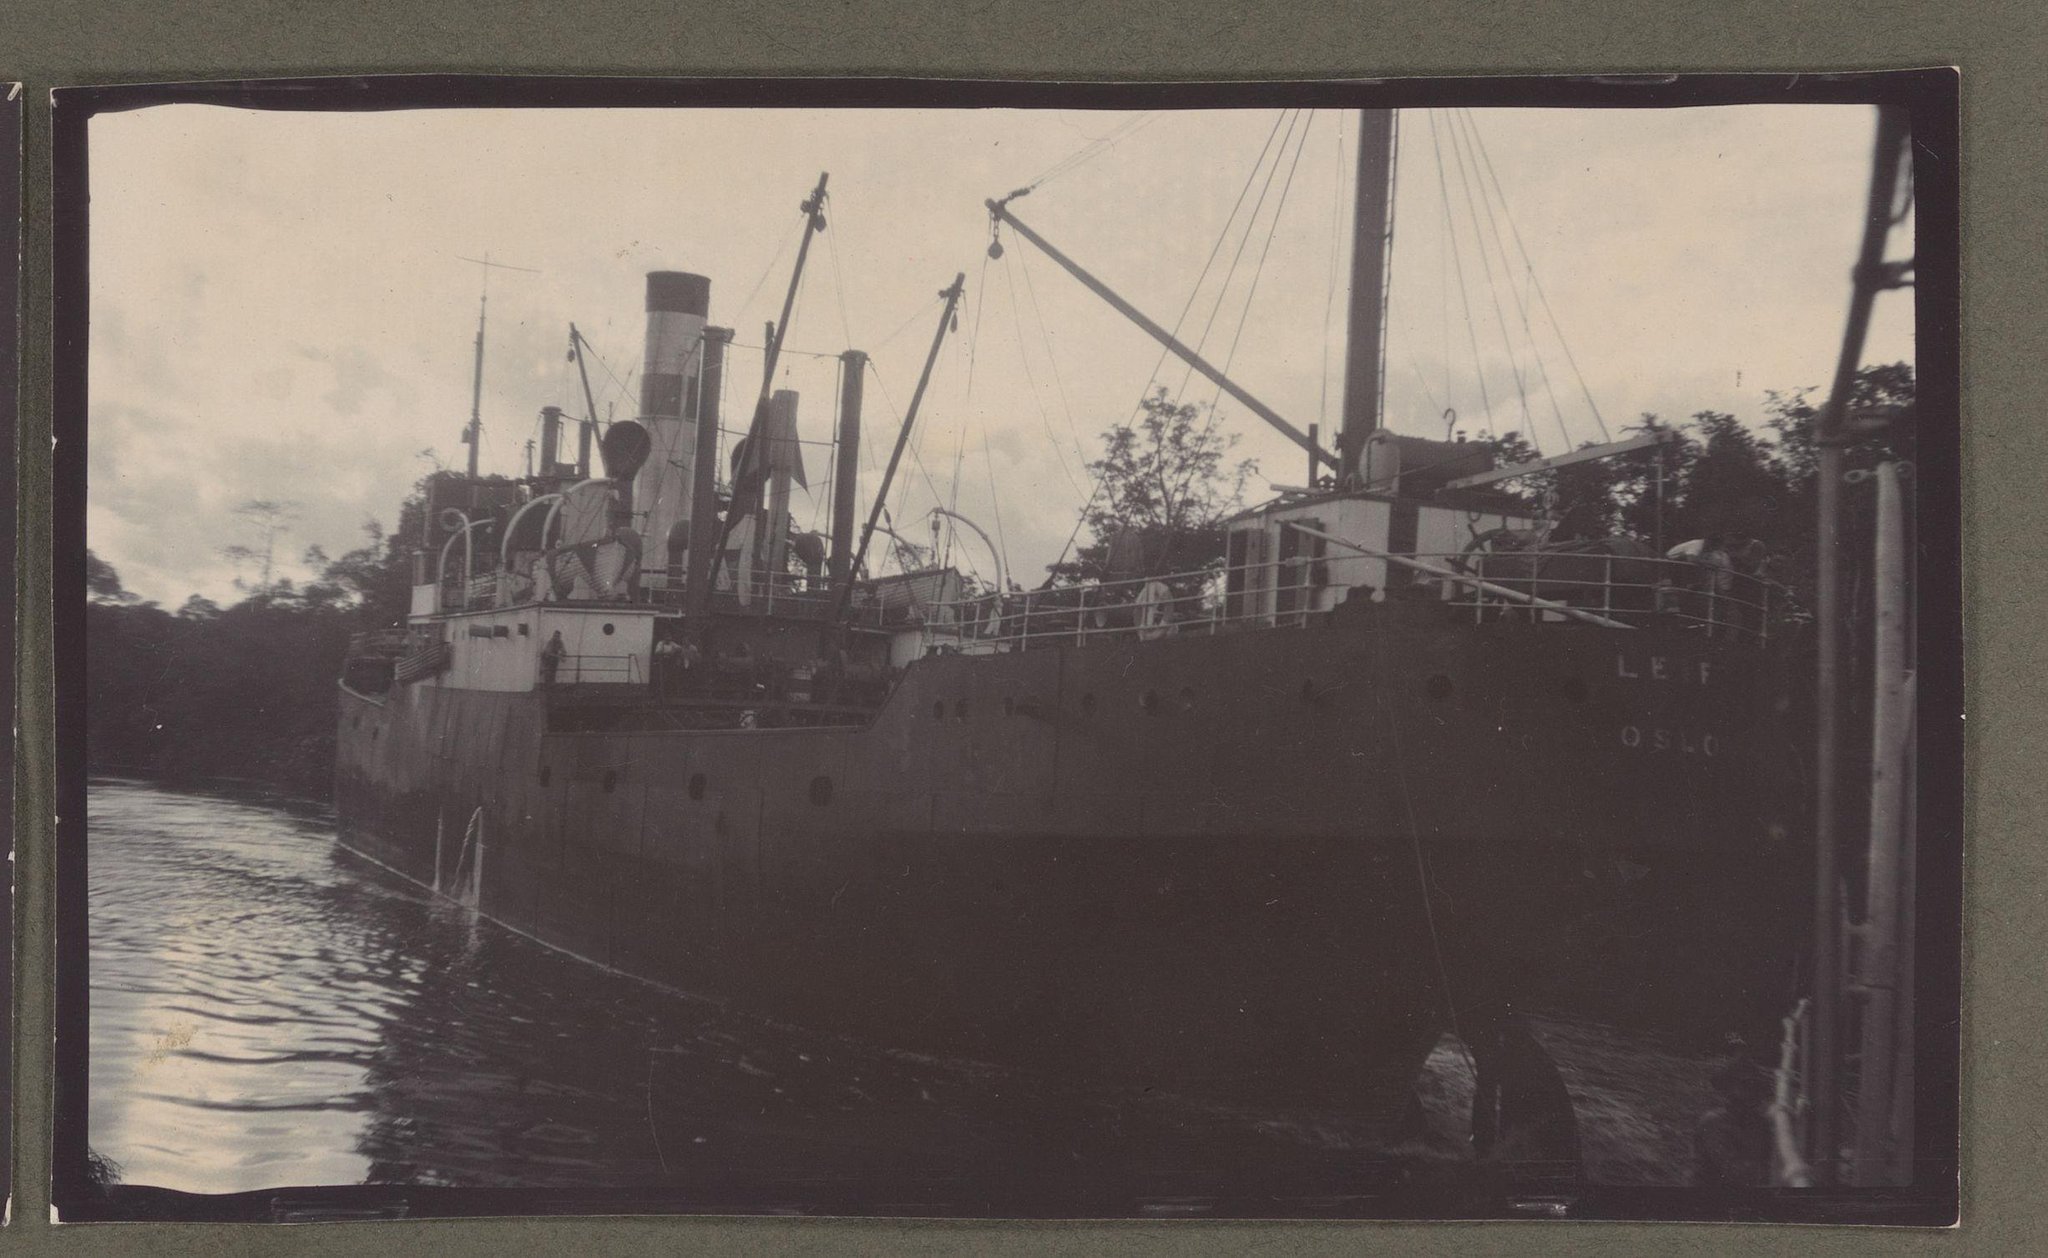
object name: photograph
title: Schip op de rivier bij Moengo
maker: Anonymous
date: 1925-1927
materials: photographic support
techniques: photography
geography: suriname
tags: jetten, familie, moengo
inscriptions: inscription: ‘June '26 ... board William ...land’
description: Het schip Leif (Oslo) op de rivier. Foto op een bladzijde van een los albumblad. Onderdeel van het ensemble met foto's van de familie van ingenieur Jetten in de mijnbouwstad Moengo in Suriname.